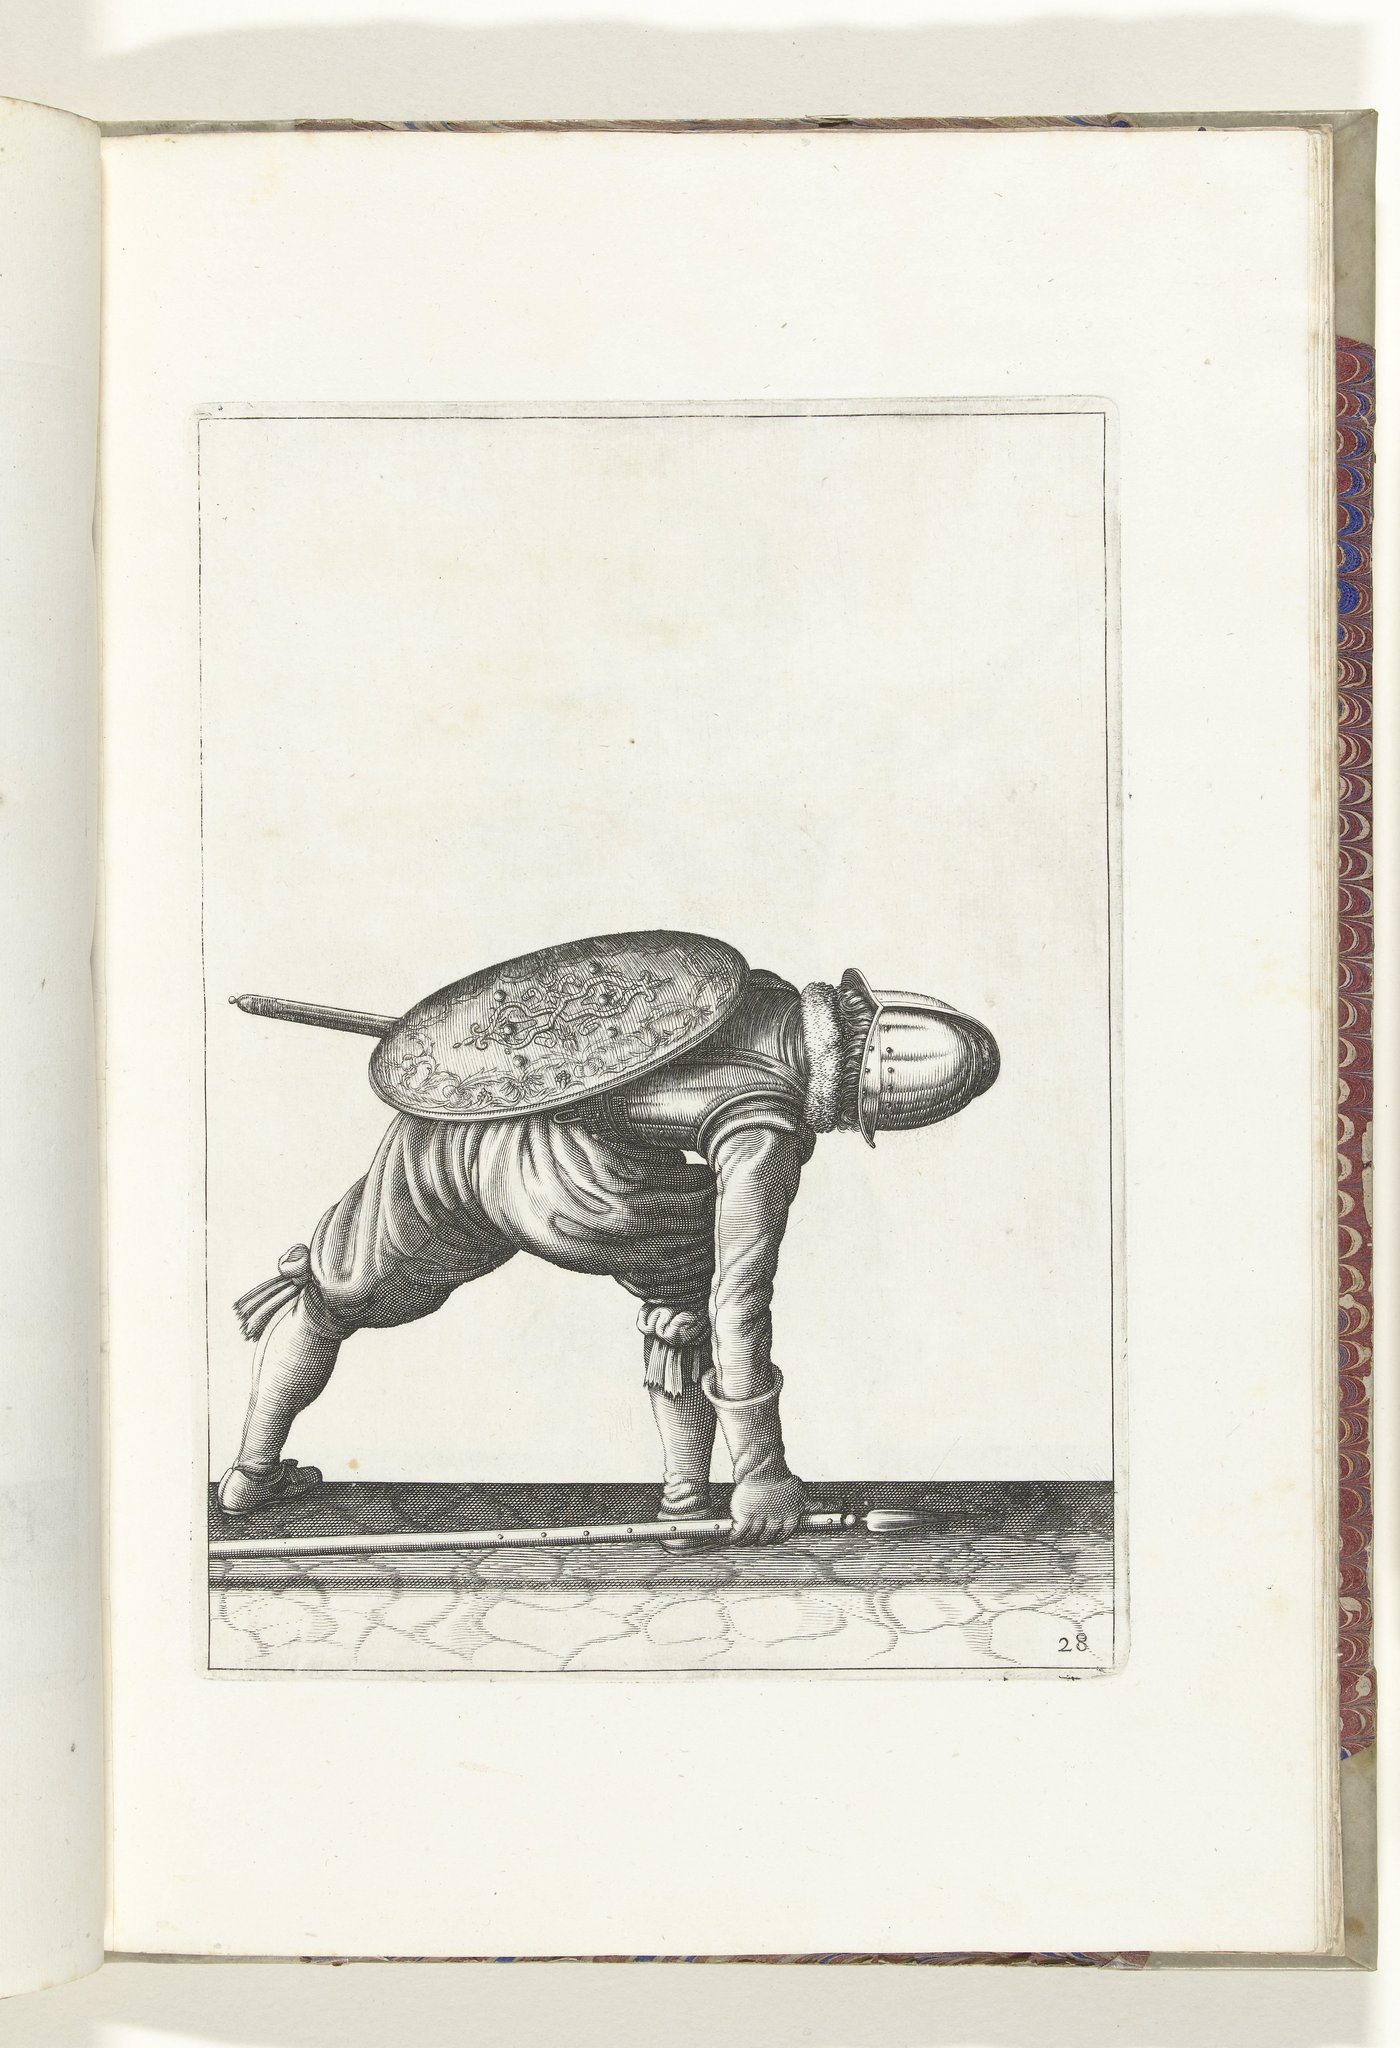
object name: print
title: De Nassausche Wapen-Handelinge, van Schilt, Spies, Rappier ende Targe : beyde figuerlick afgebeelt, ende gestelt na de nieu ordening [van] (...) Maurits van Nassau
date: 1616-1618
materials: paper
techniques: engraving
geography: northern netherlands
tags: the hague, maurice (prince of orange), handling of weapons ~ military training, weapons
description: Illustratie in: Adam van Breen, De Nassausche Wapen-Handelinge, van Schilt, Spies, Rappier ende Targe : beyde figuerlick afgebeelt, ende gestelt na de nieu ordening [van] ... Maurits van Nassau, 's-Gravenhage, [Aert Meuris] 1618, plaat nr. 28. In het exemplaar in de collectie van de Rijksmuseum Research Library (326 F 22).